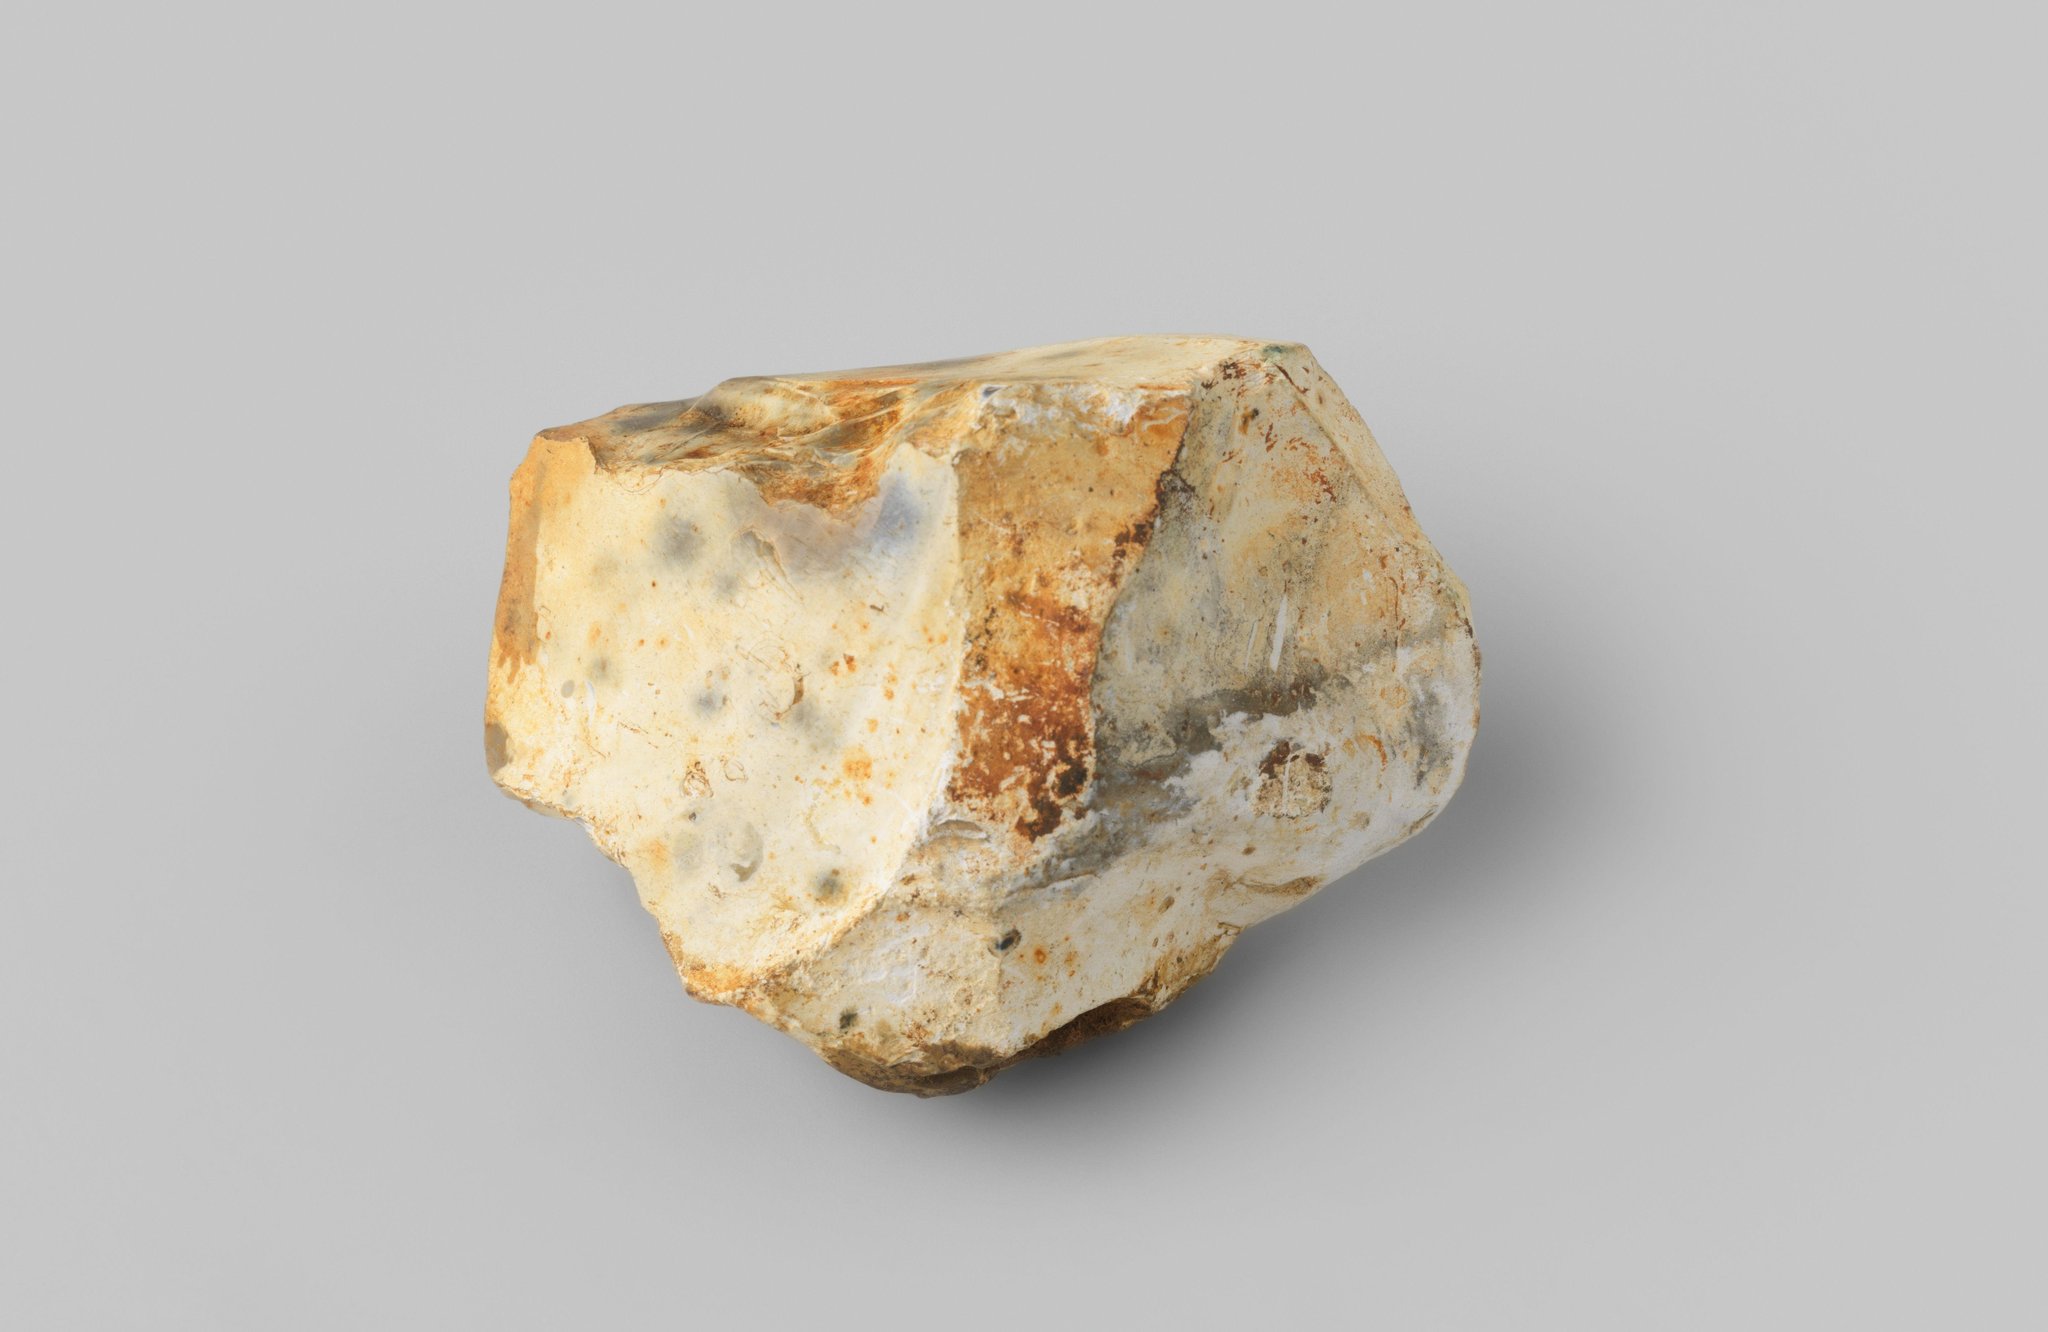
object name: gunflint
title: Vuursteen van een handwapen uit het wrak van de Oost-Indiëvaarder Hollandia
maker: Anonymous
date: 1700-1743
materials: stone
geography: netherlands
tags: verenigde oostindische compagnie, hollandia (schip), annet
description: Hand weapon, flint; lump of raw material with percussion marks.